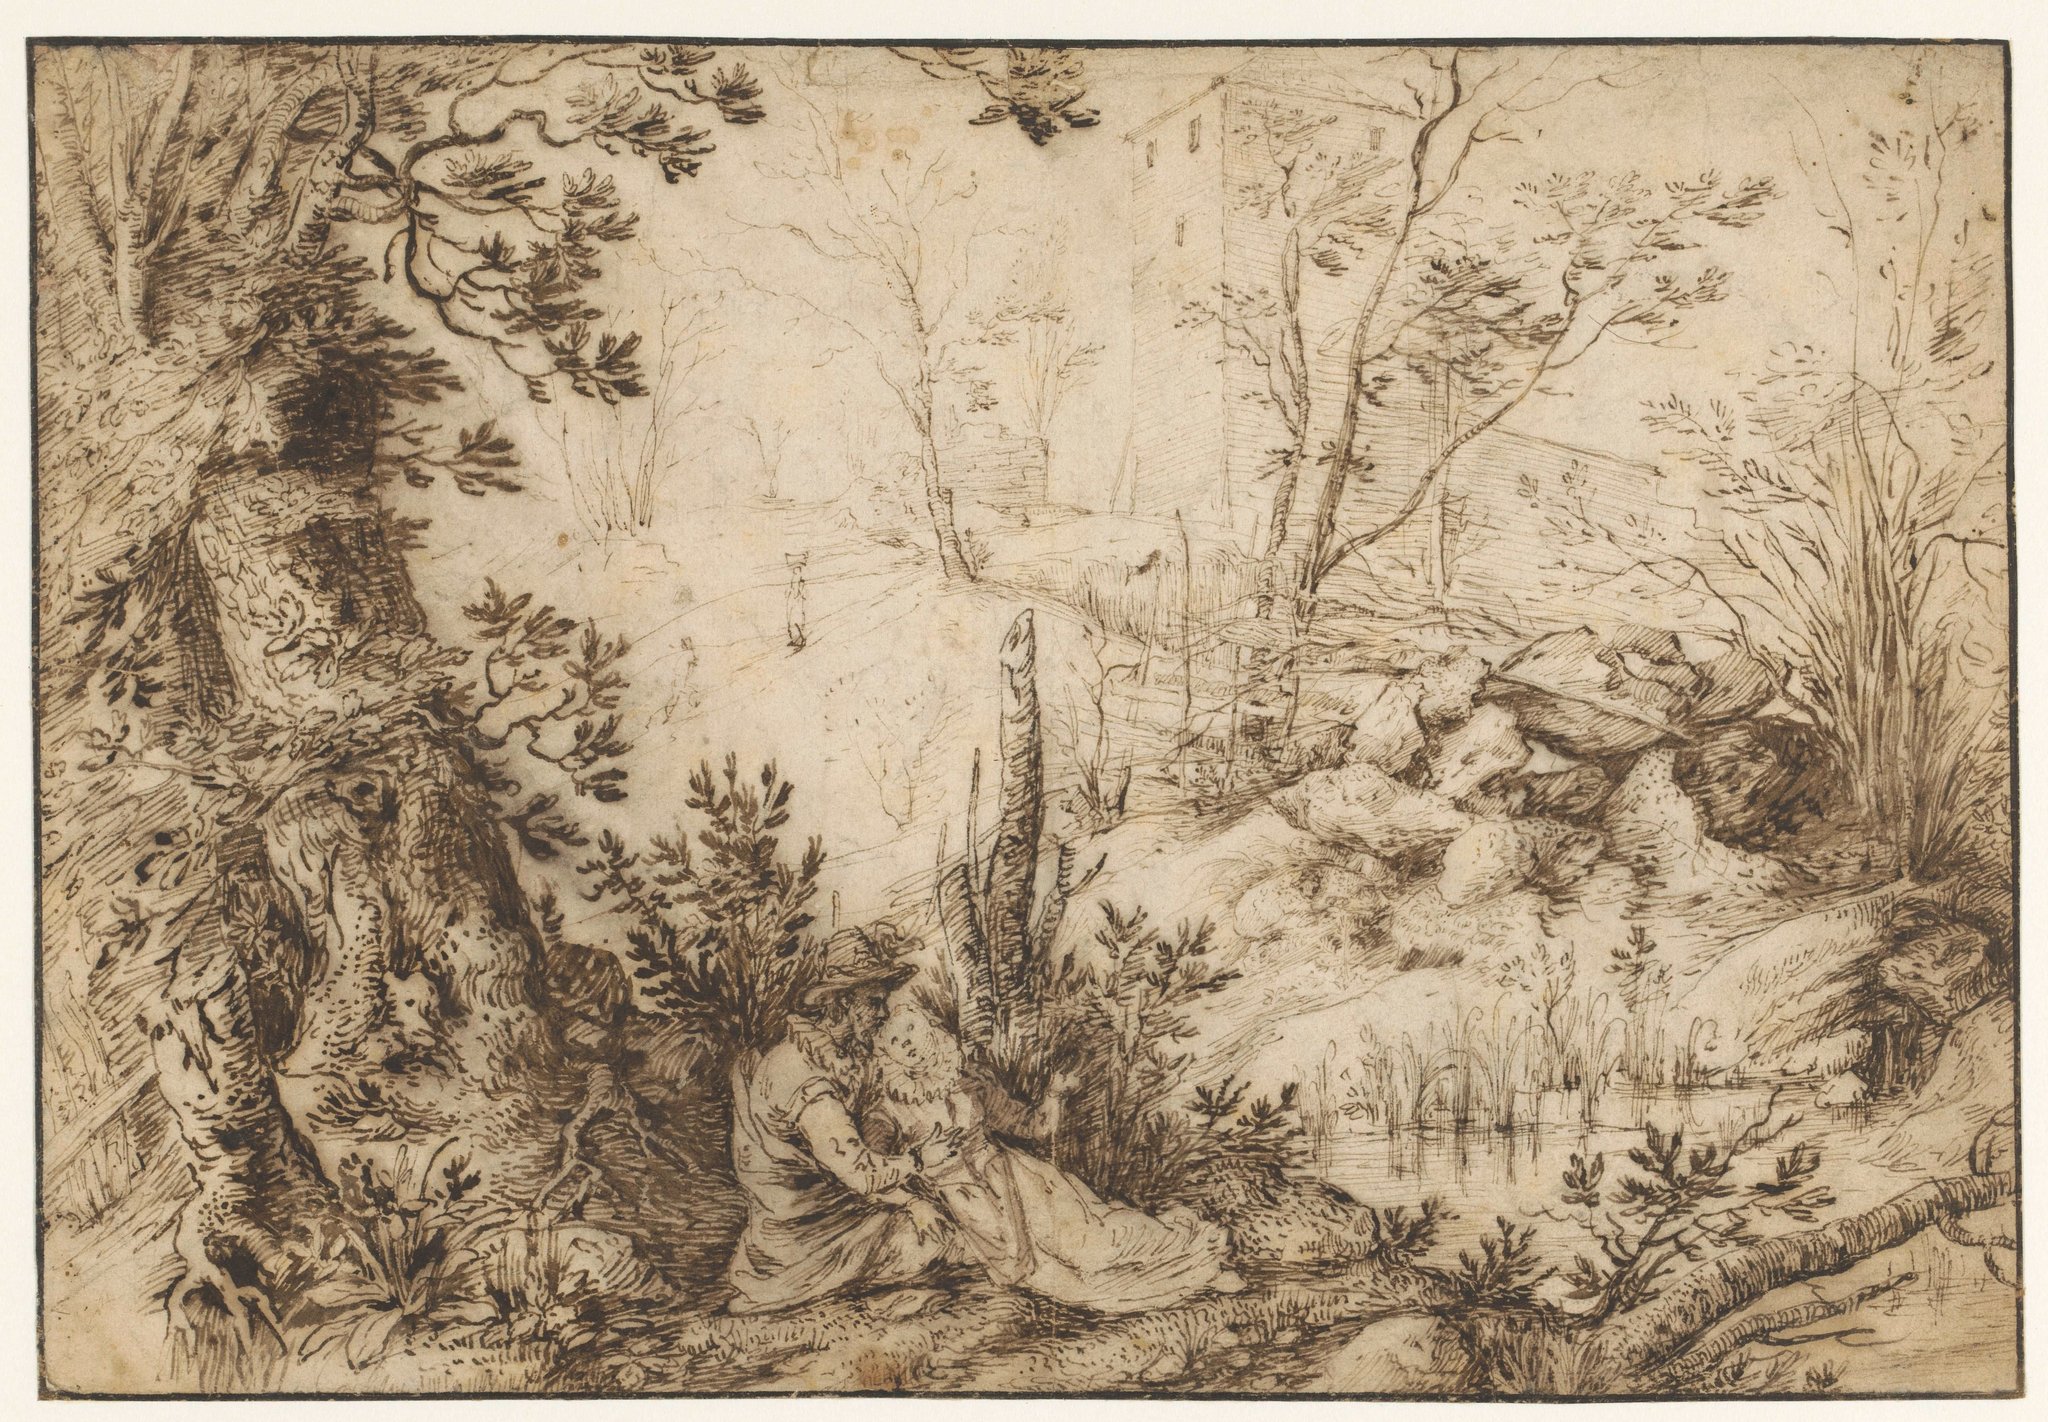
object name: drawing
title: Landschap met een vrijend paartje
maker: paulus willemsz. van vianen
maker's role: draughtsman, jeweler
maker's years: 1570-1614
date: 1580-1613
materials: ink, paper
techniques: pen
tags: forest, wood, lovers' meeting